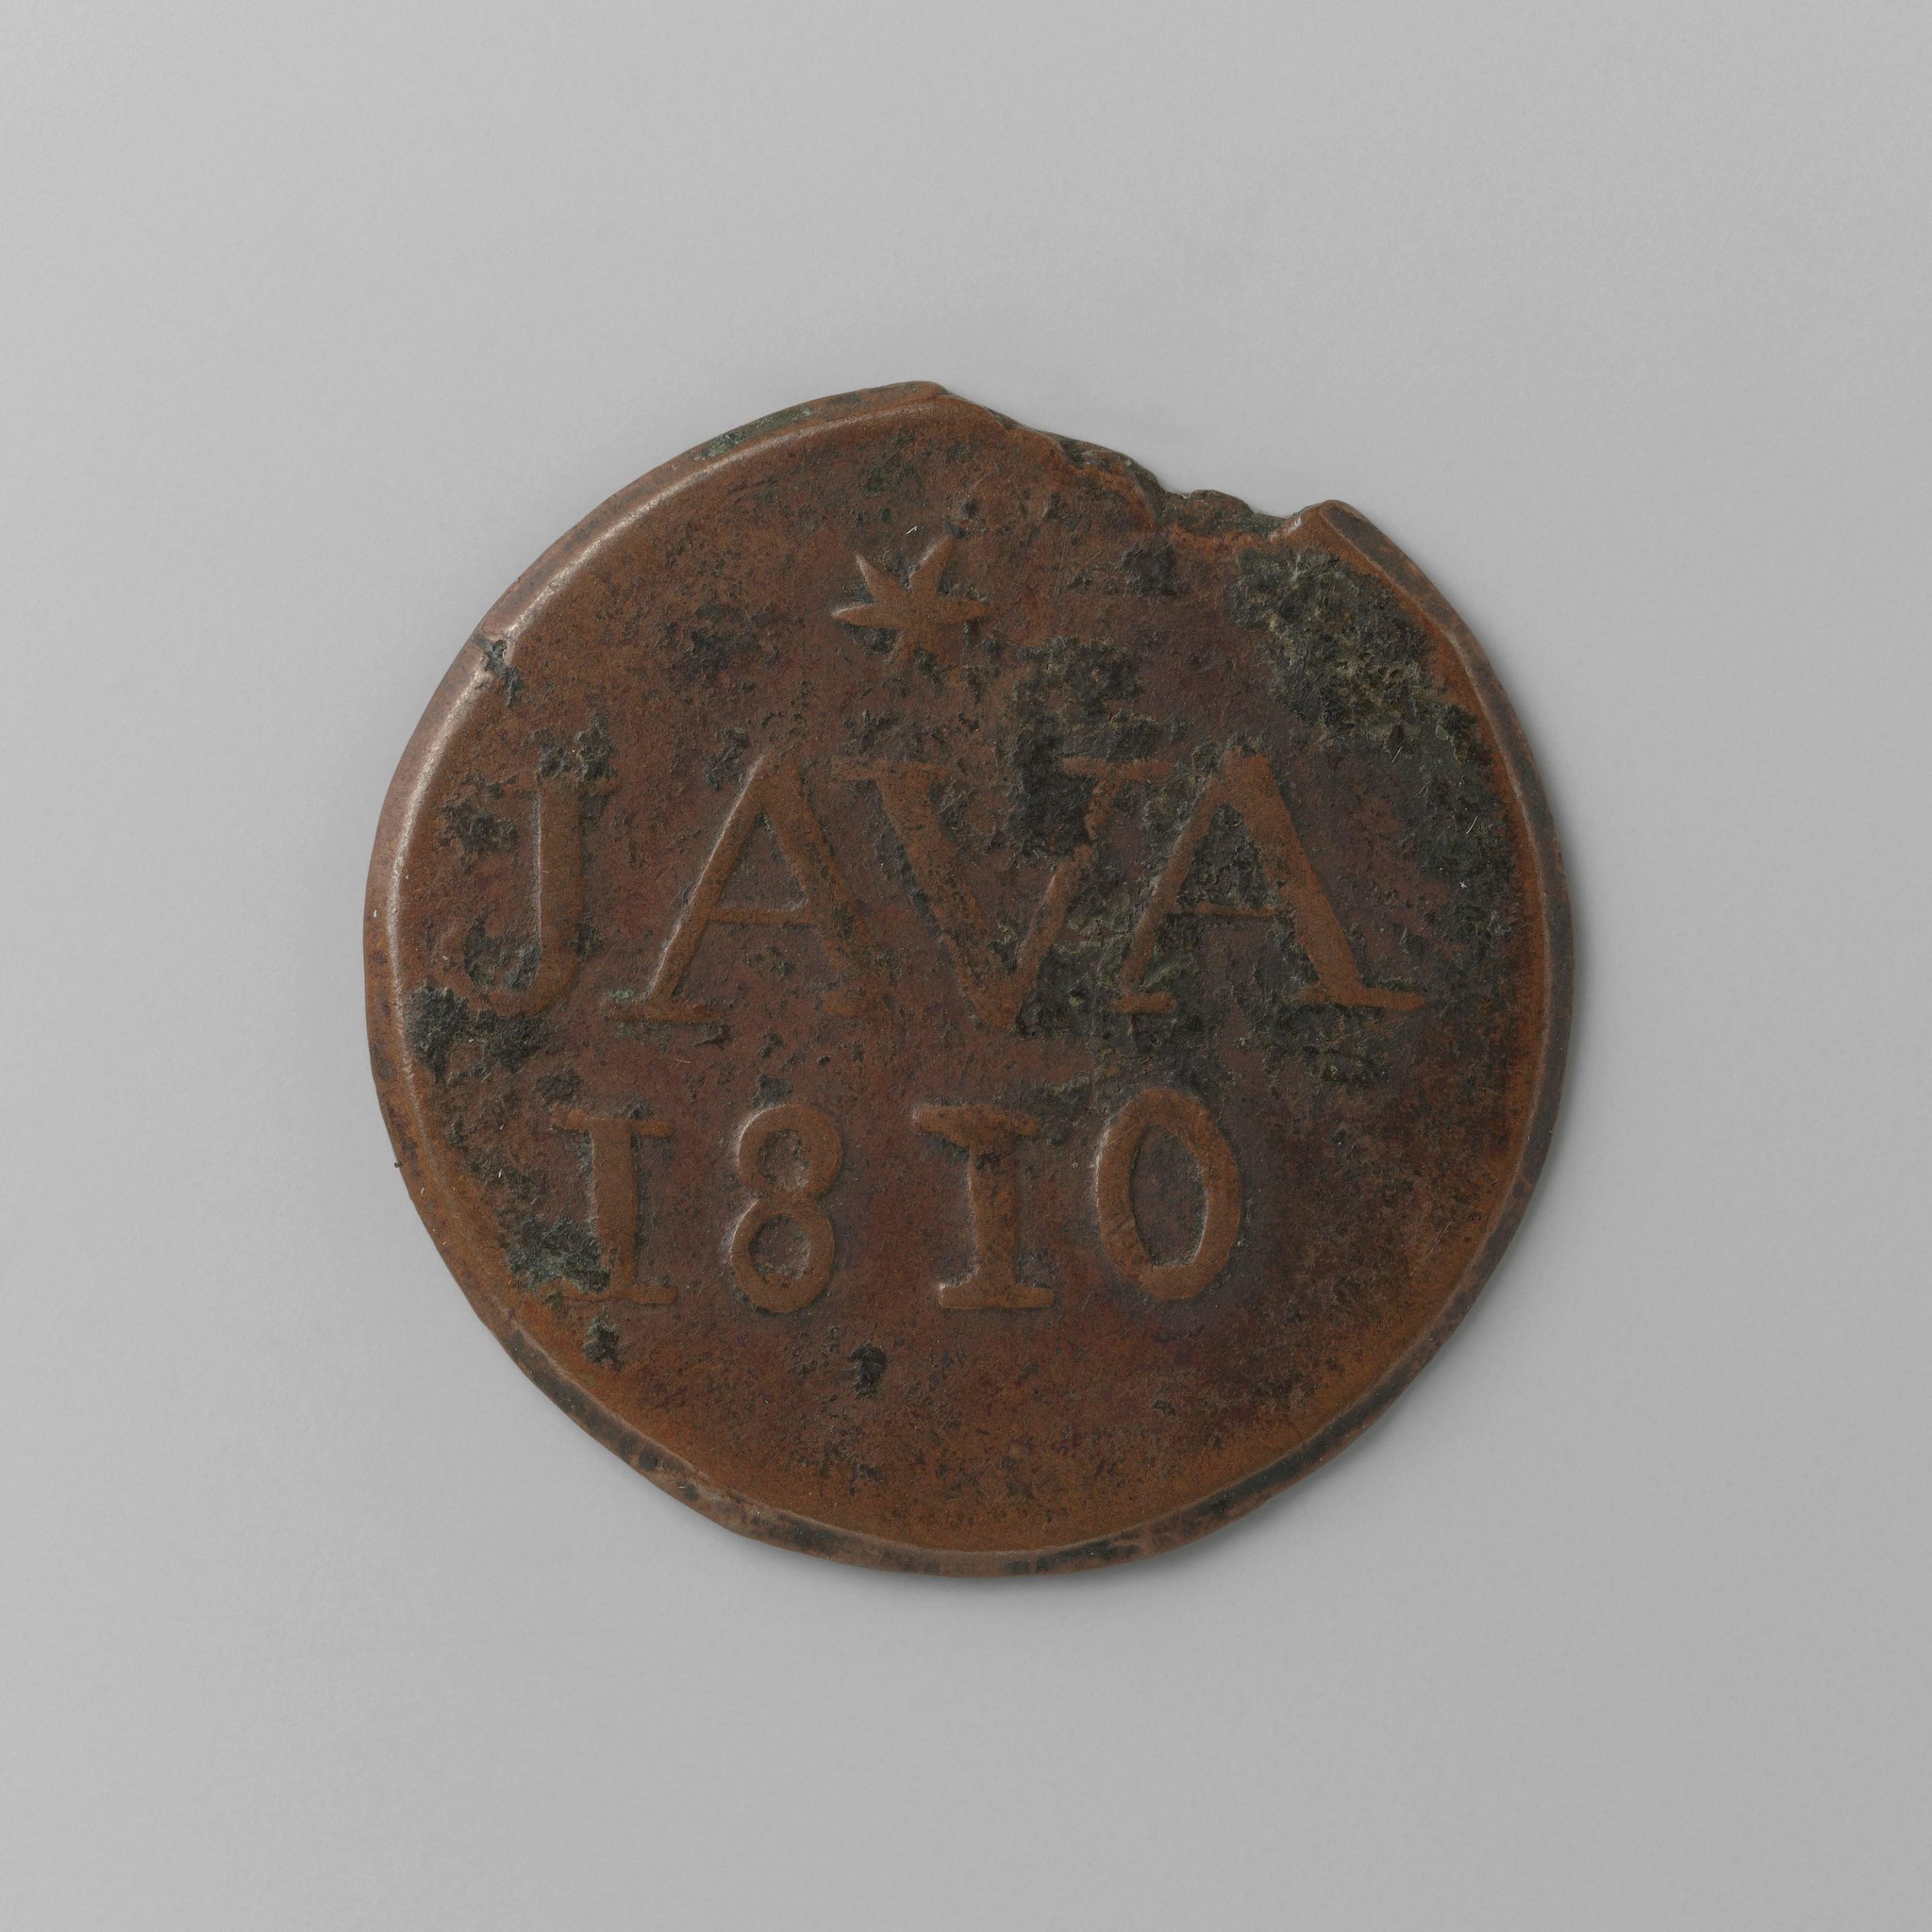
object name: coin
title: Nederlands Indië, duit Java,1810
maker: louis napoleon (king of holland)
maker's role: koning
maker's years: 1778-1846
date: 1810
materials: copper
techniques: striking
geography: surabaya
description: Koperen munt. Voorzijde: initialen L en N van Lodewijk Napoleon. Daarboven muntteken. Keerzijde: eenregelig opschrift, waaronder jaartal. Boven opschrift muntteken.